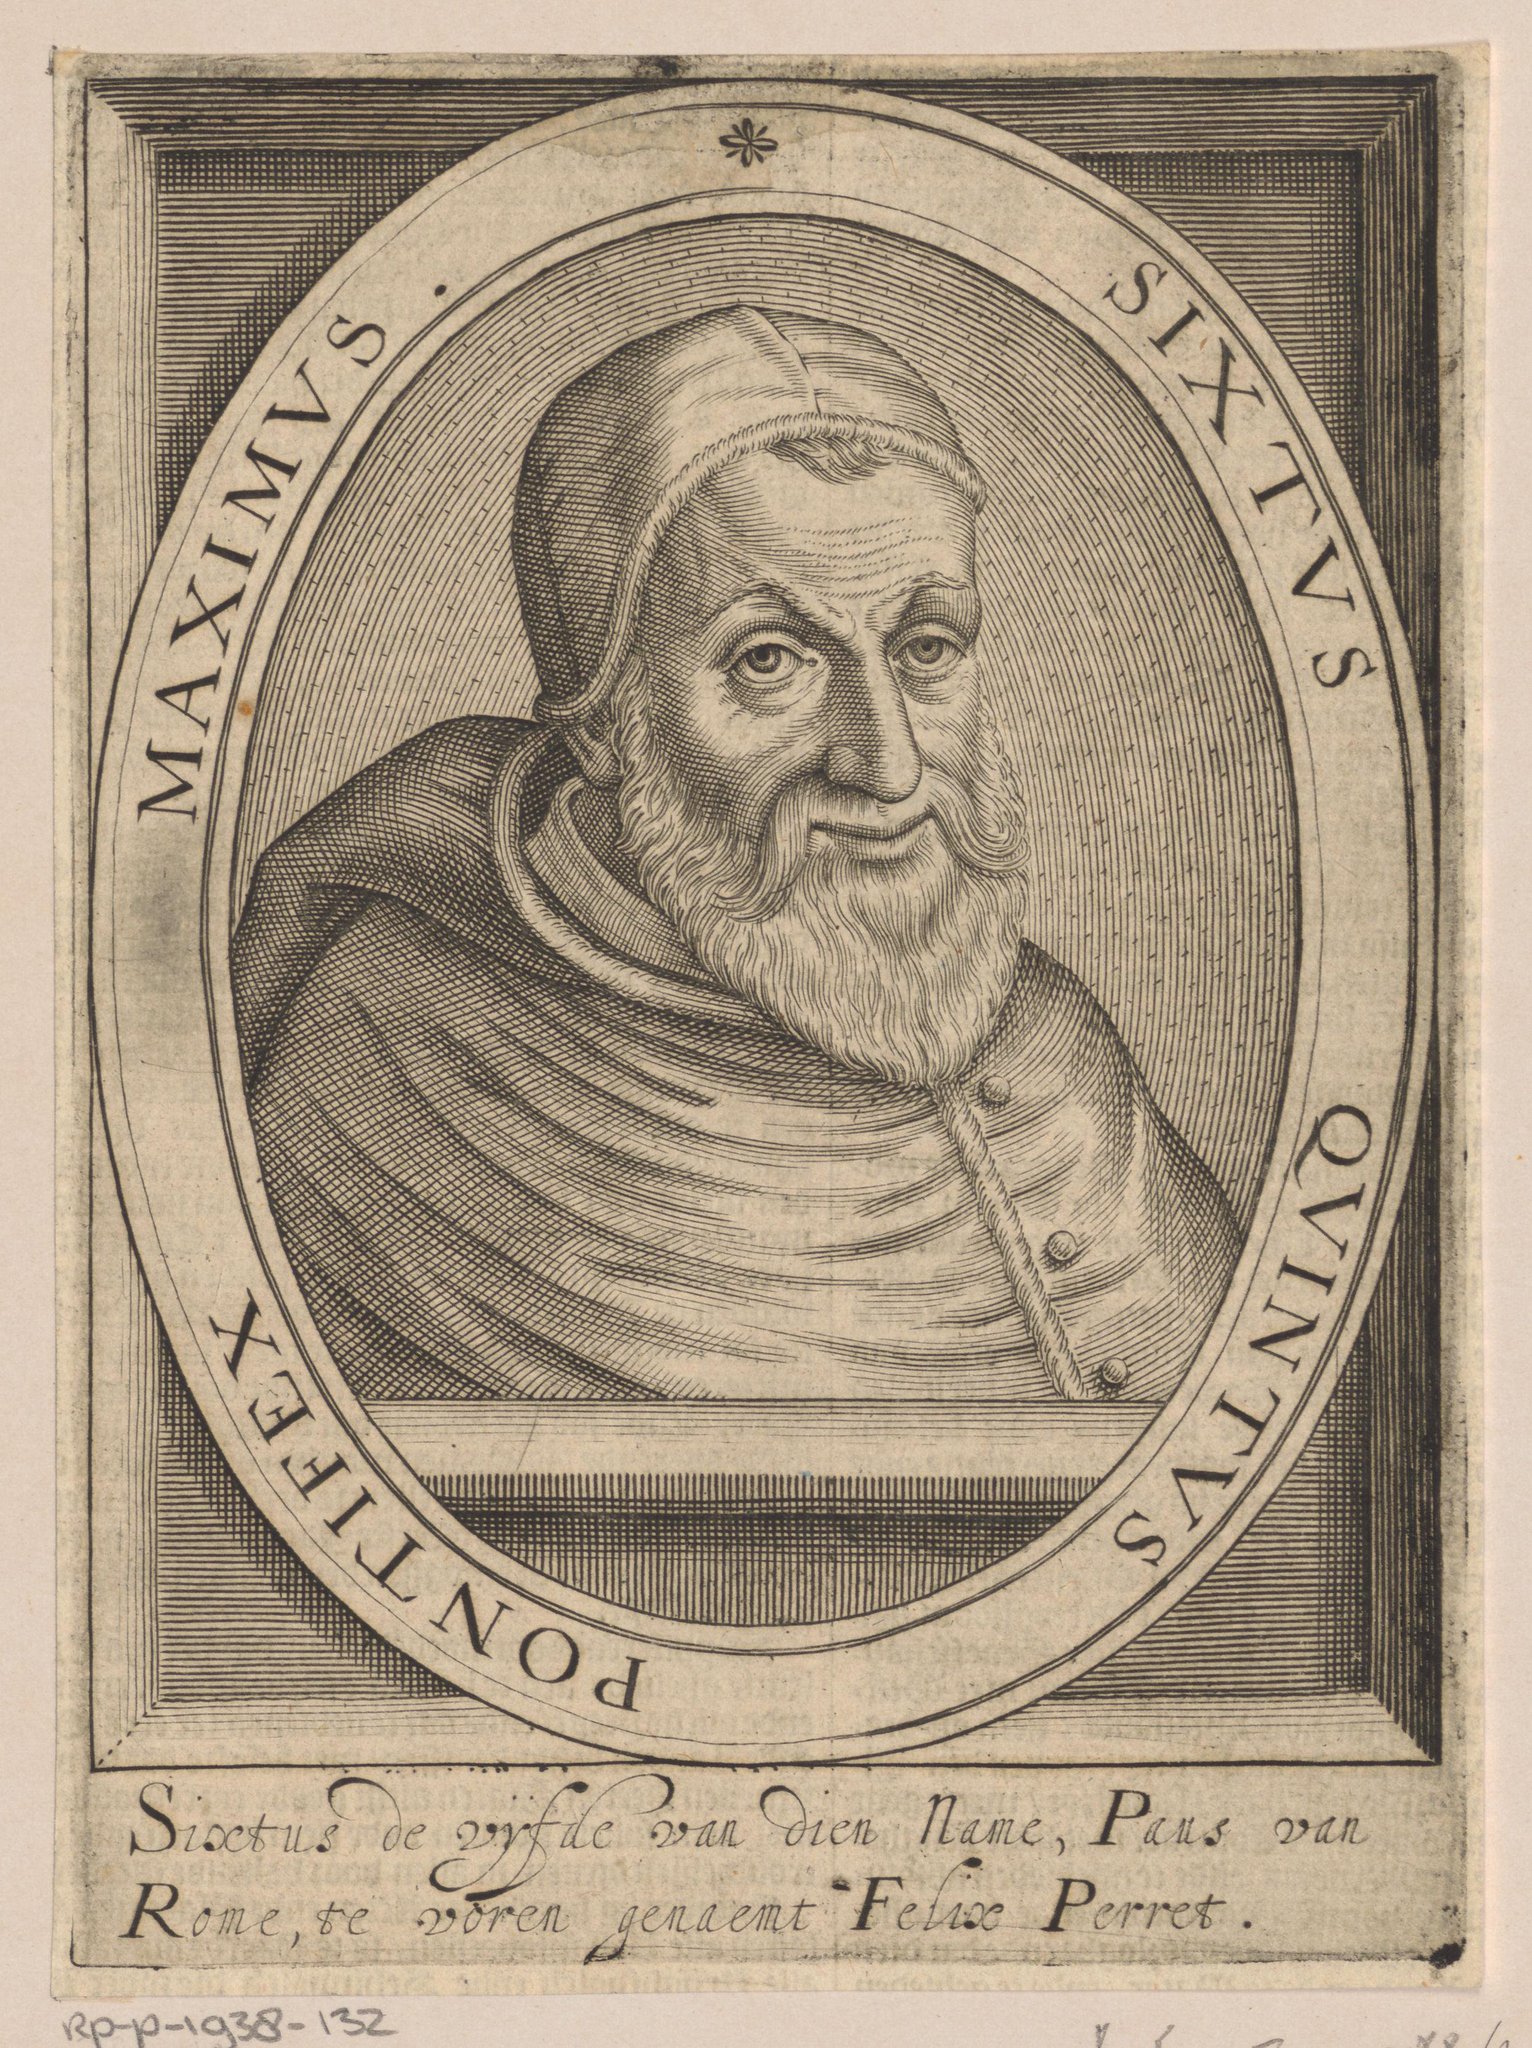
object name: print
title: Portret van Sixtus V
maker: Anonymous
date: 1614-1623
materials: paper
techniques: engraving, letterpress printing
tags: rome, sixtus v, historical persons, pope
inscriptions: collector's mark: Lugt 2228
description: Prent gebruikt in meerdere edities van Emanuel van Meterens 'Nederlantsche historien'. Zie bijvoorbeeld: Meteren, Emanuel van. Historie der Neder-landscher ende haerder na-buren oorlogen ende geschiedenissen (...). Den Haag: Hillebrant Jacobsz., 1614.